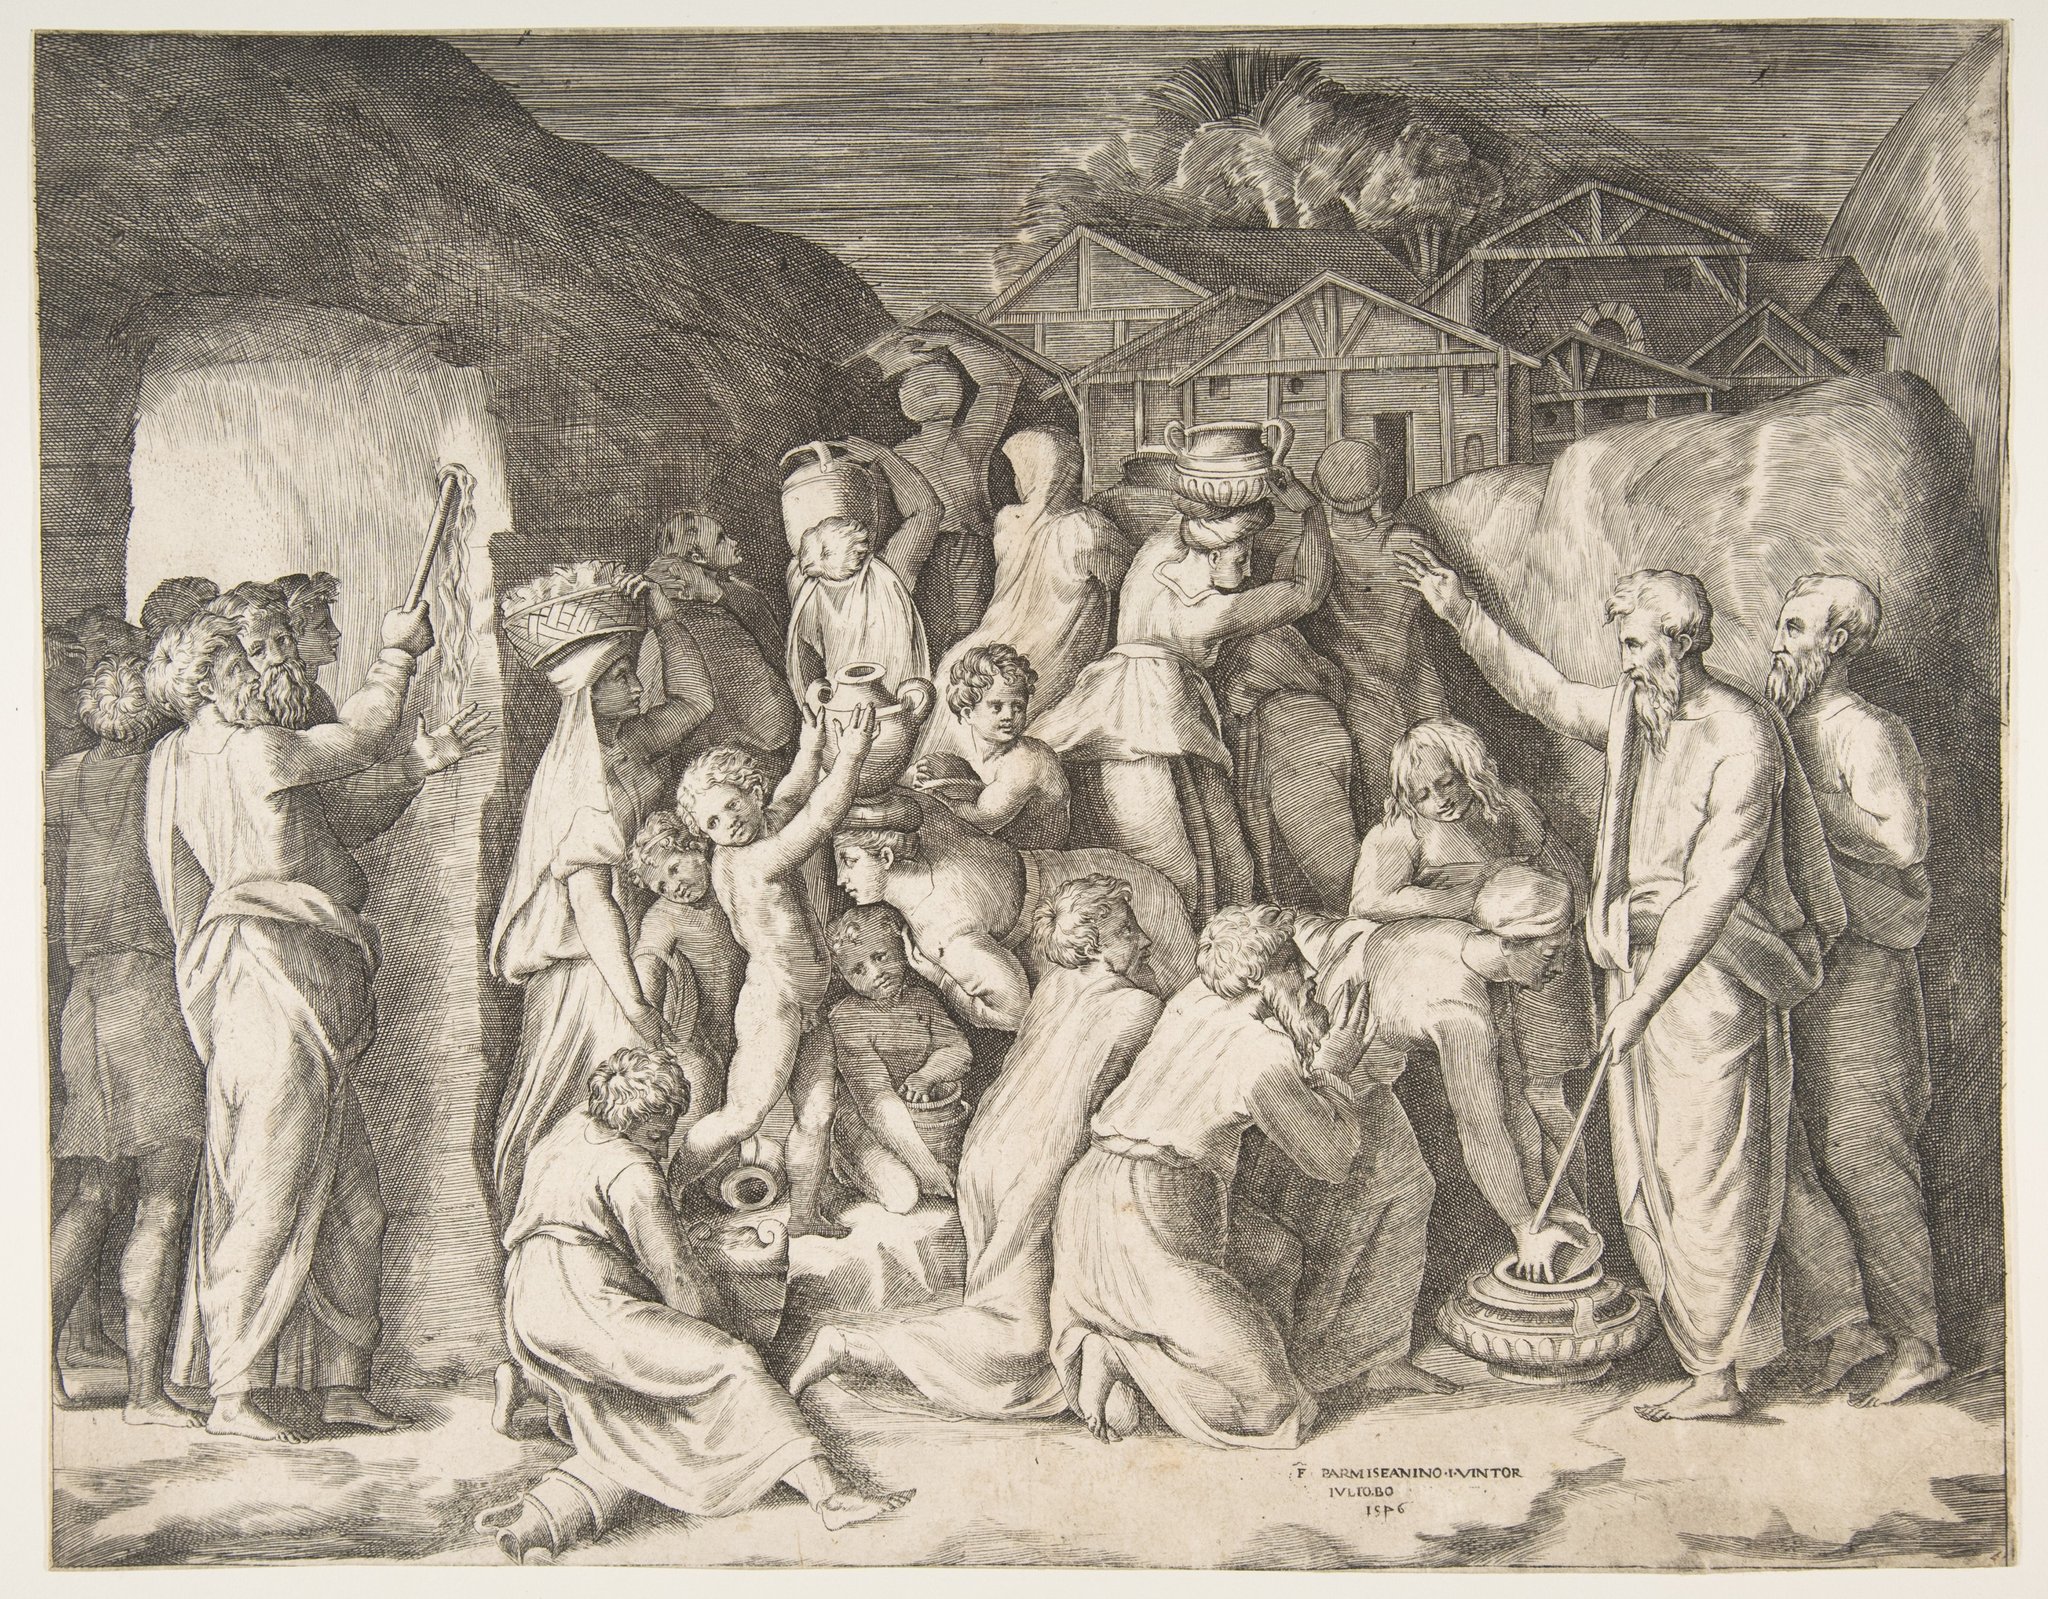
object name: print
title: Moses at right telling the Israelites to gather the manna and at left Moses striking the rock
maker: giulio bonasone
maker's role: artist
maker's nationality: italian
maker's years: 1510-1576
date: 1546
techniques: engraving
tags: men,women,moses,manna